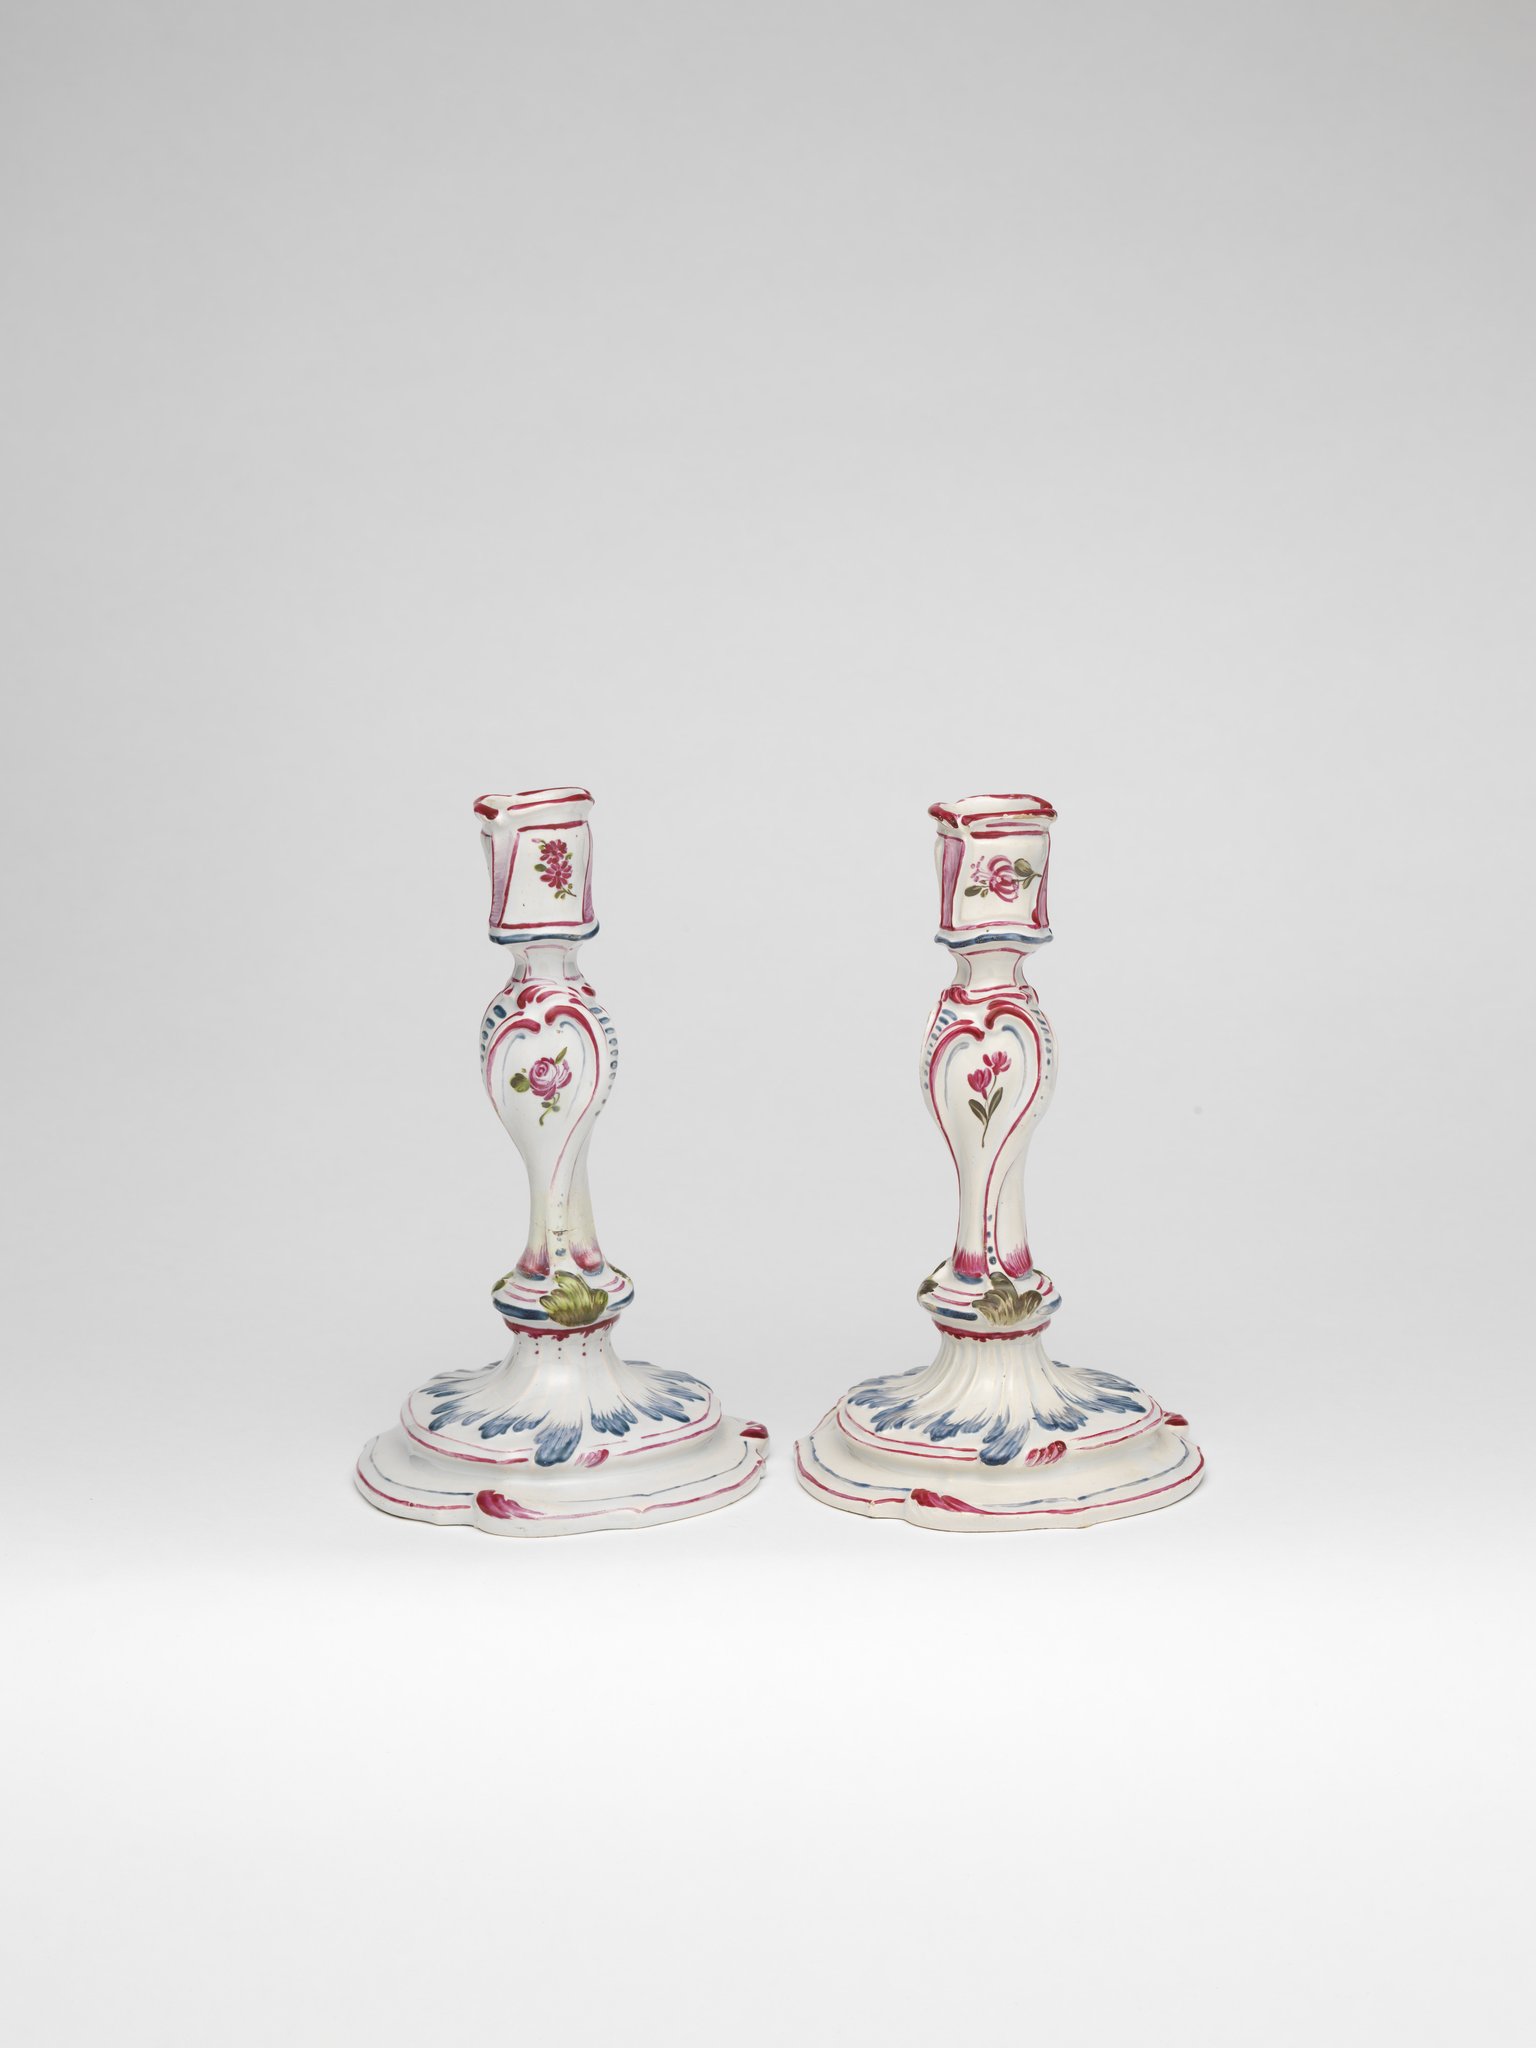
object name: candlestick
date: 1750-1760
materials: faience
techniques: glazing